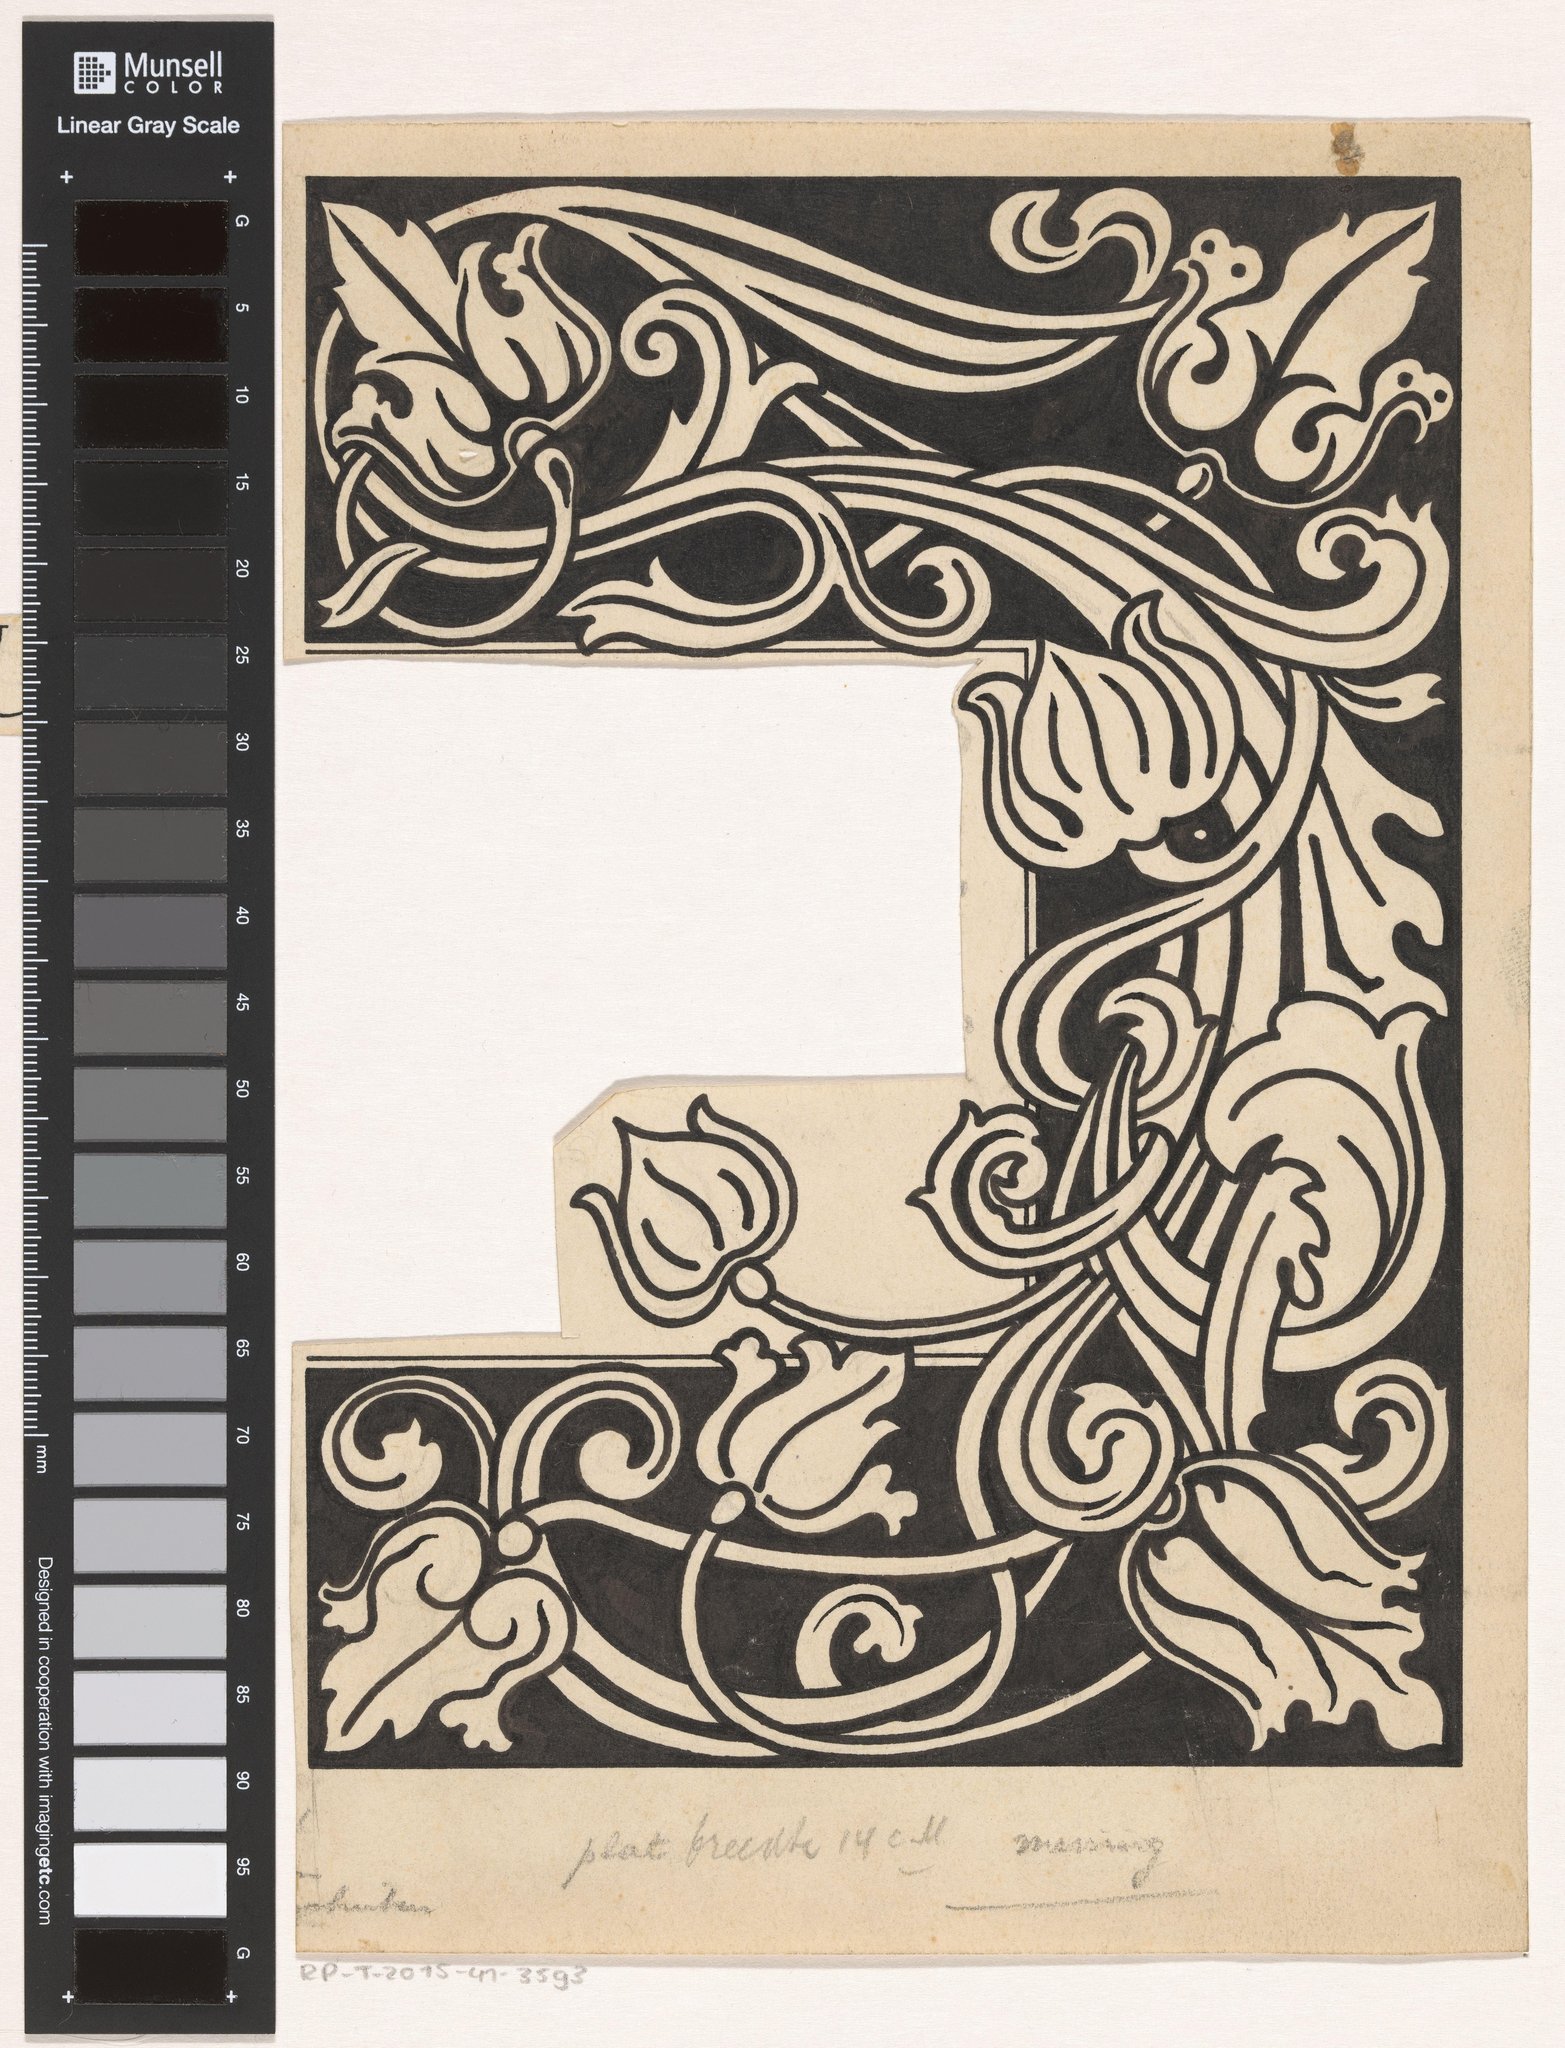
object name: study for binding design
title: Bandontwerp met gestileerde bloemen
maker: Anonymous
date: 1890-1930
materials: ink, paper, pencil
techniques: brush, pen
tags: flowers ~ ornament - aa - stylized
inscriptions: clichéaanwijzing, recto, handgeschreven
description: Ontwerp voor een boek(band) van één van de werken van Louis Couperus.